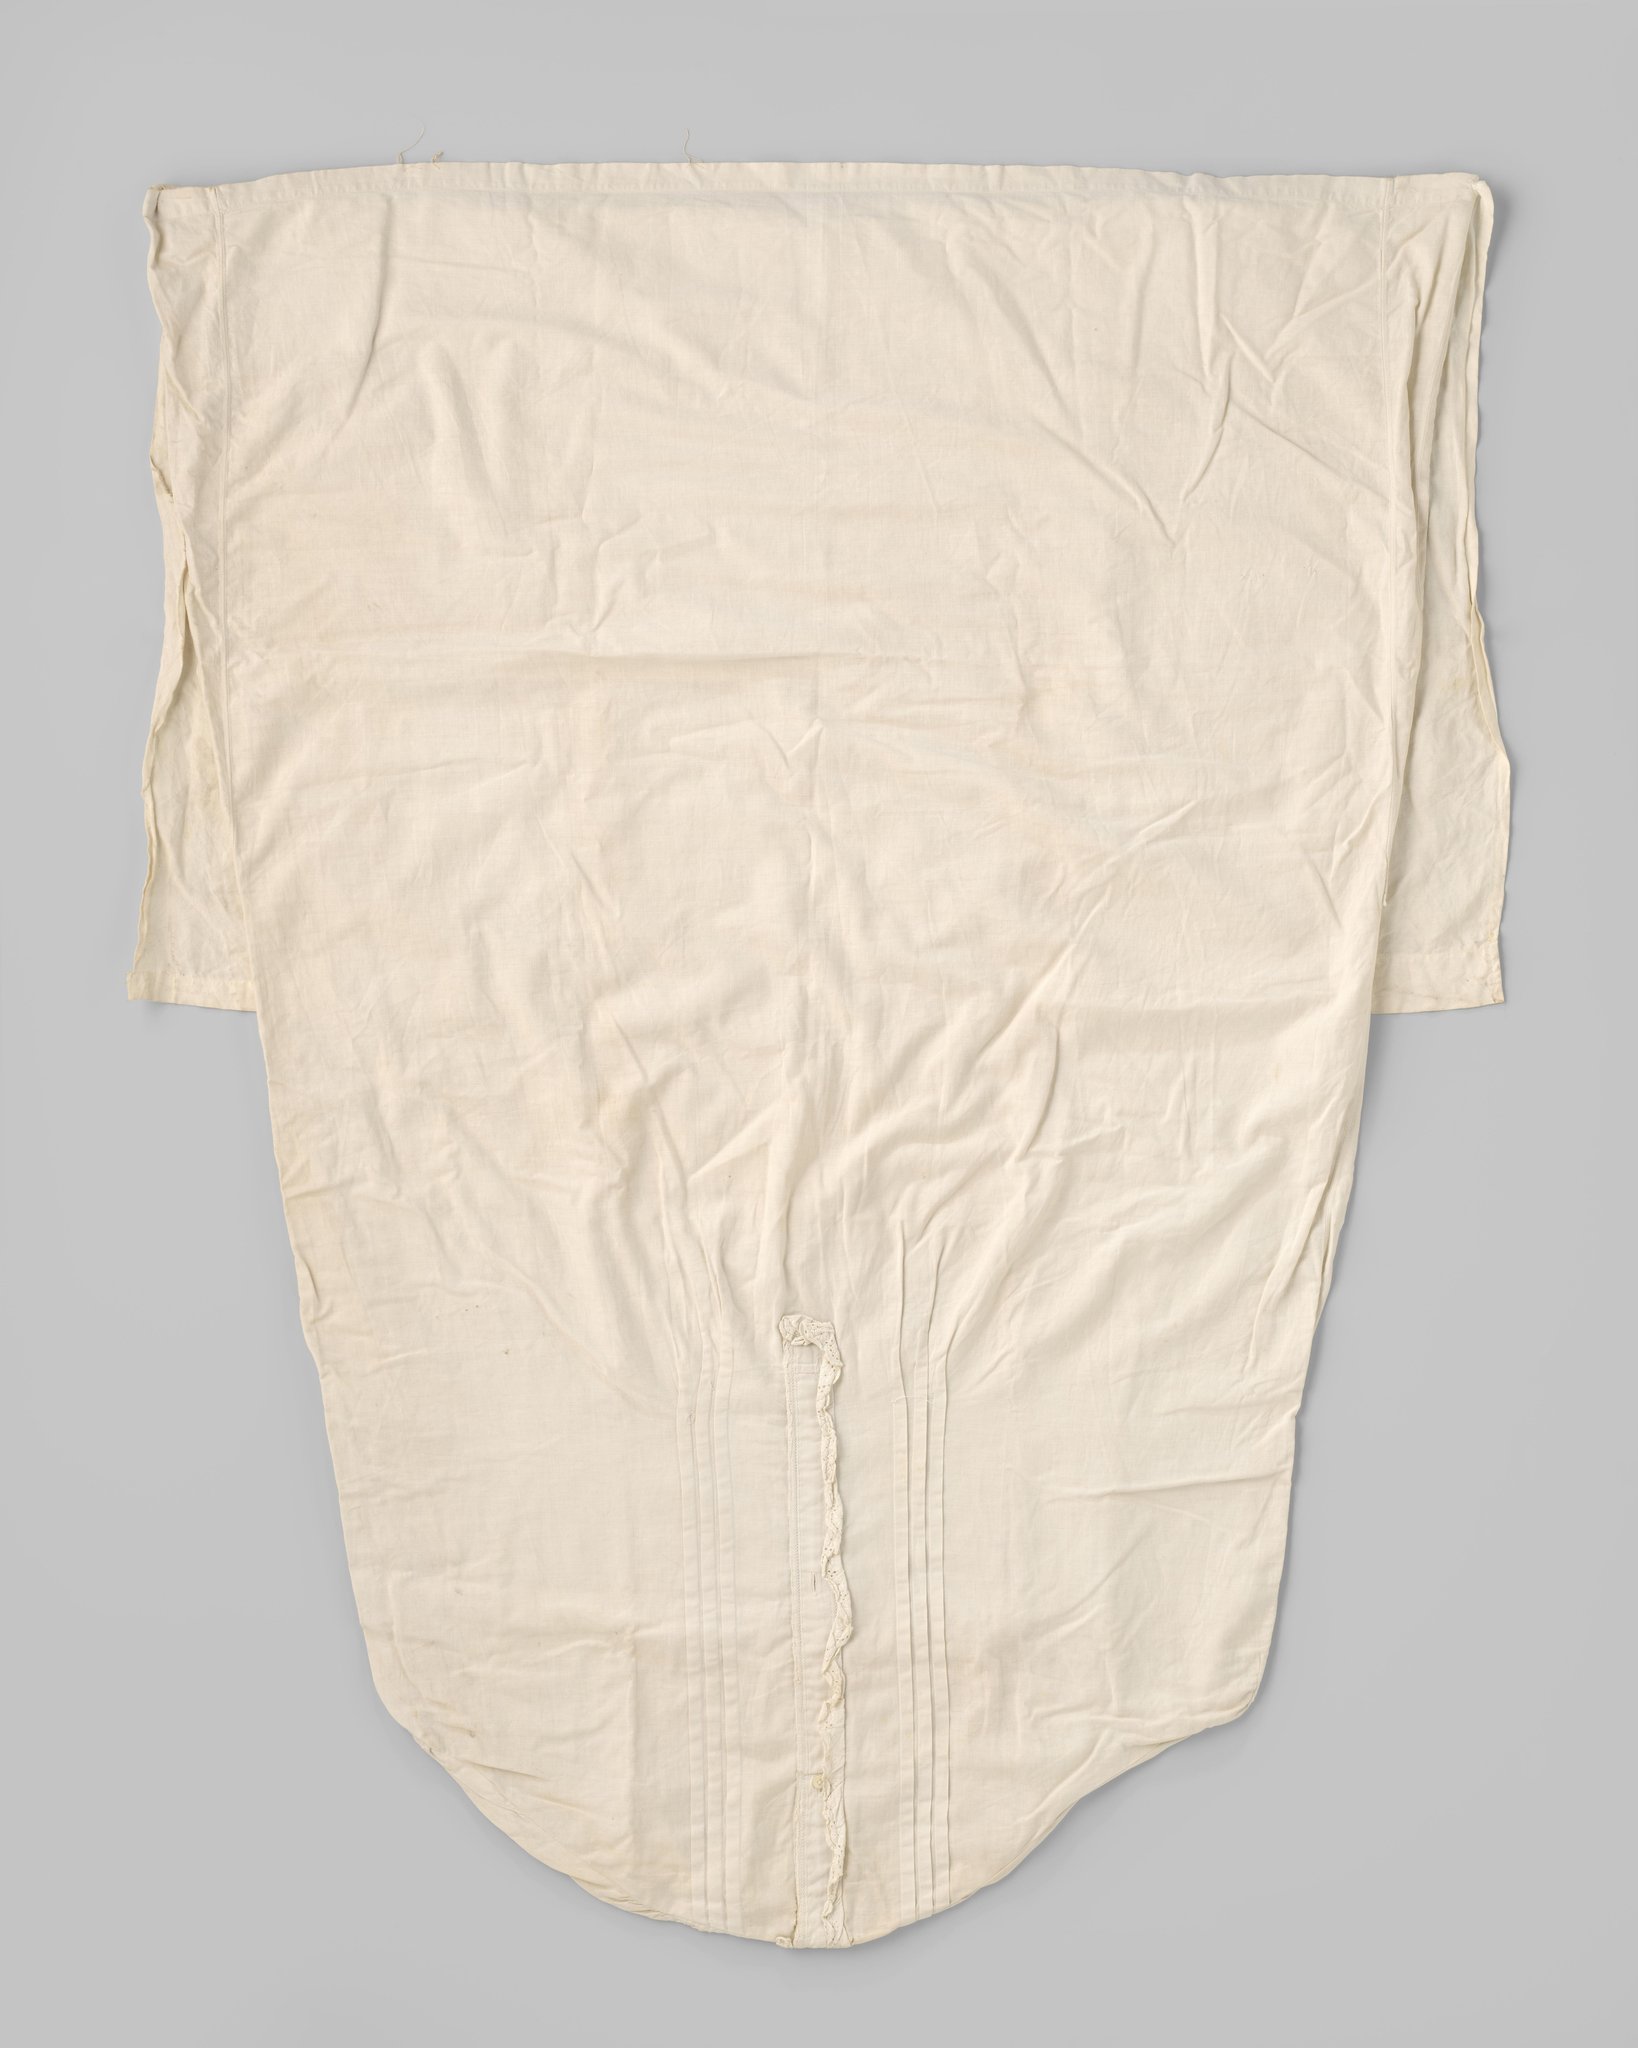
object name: covering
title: Tot hoes vermaakt nachthemd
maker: Anonymous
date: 1875-1925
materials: textile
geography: europe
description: Aan de voorzijde twee keer drie verticale oprijgjes en een rand met geschulpt kant